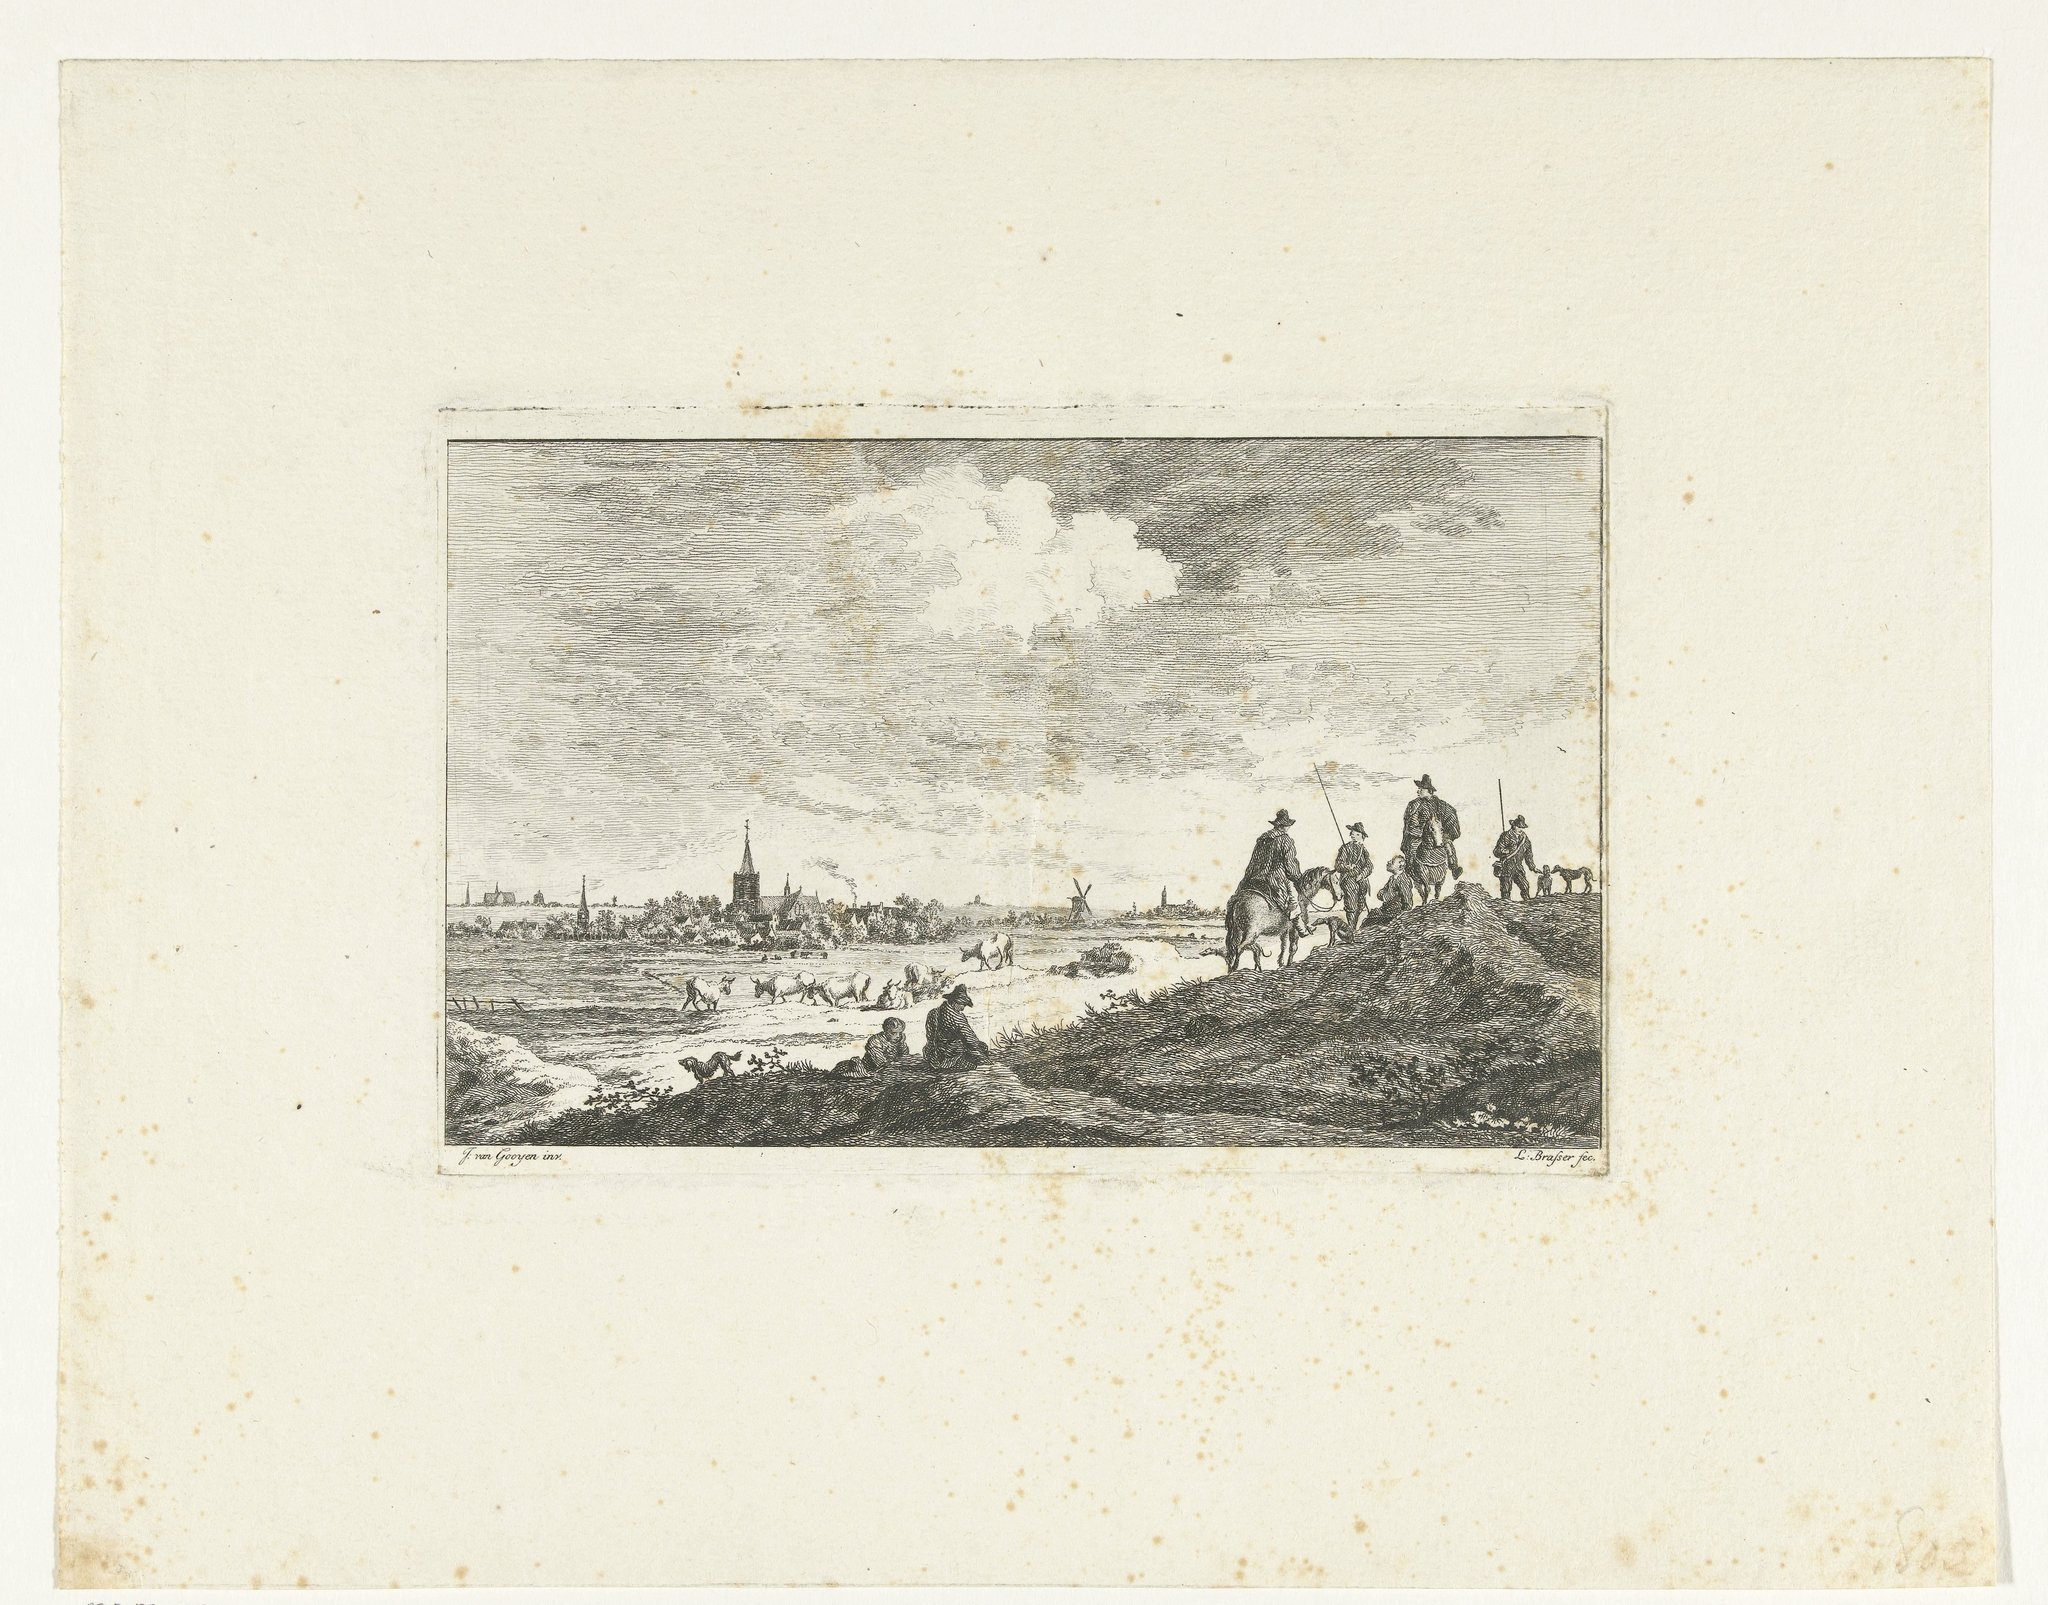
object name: print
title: Landschap met jagers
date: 1727-1793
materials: paper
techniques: etching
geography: netherlands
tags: hunter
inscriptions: collector's mark: Lugt 240